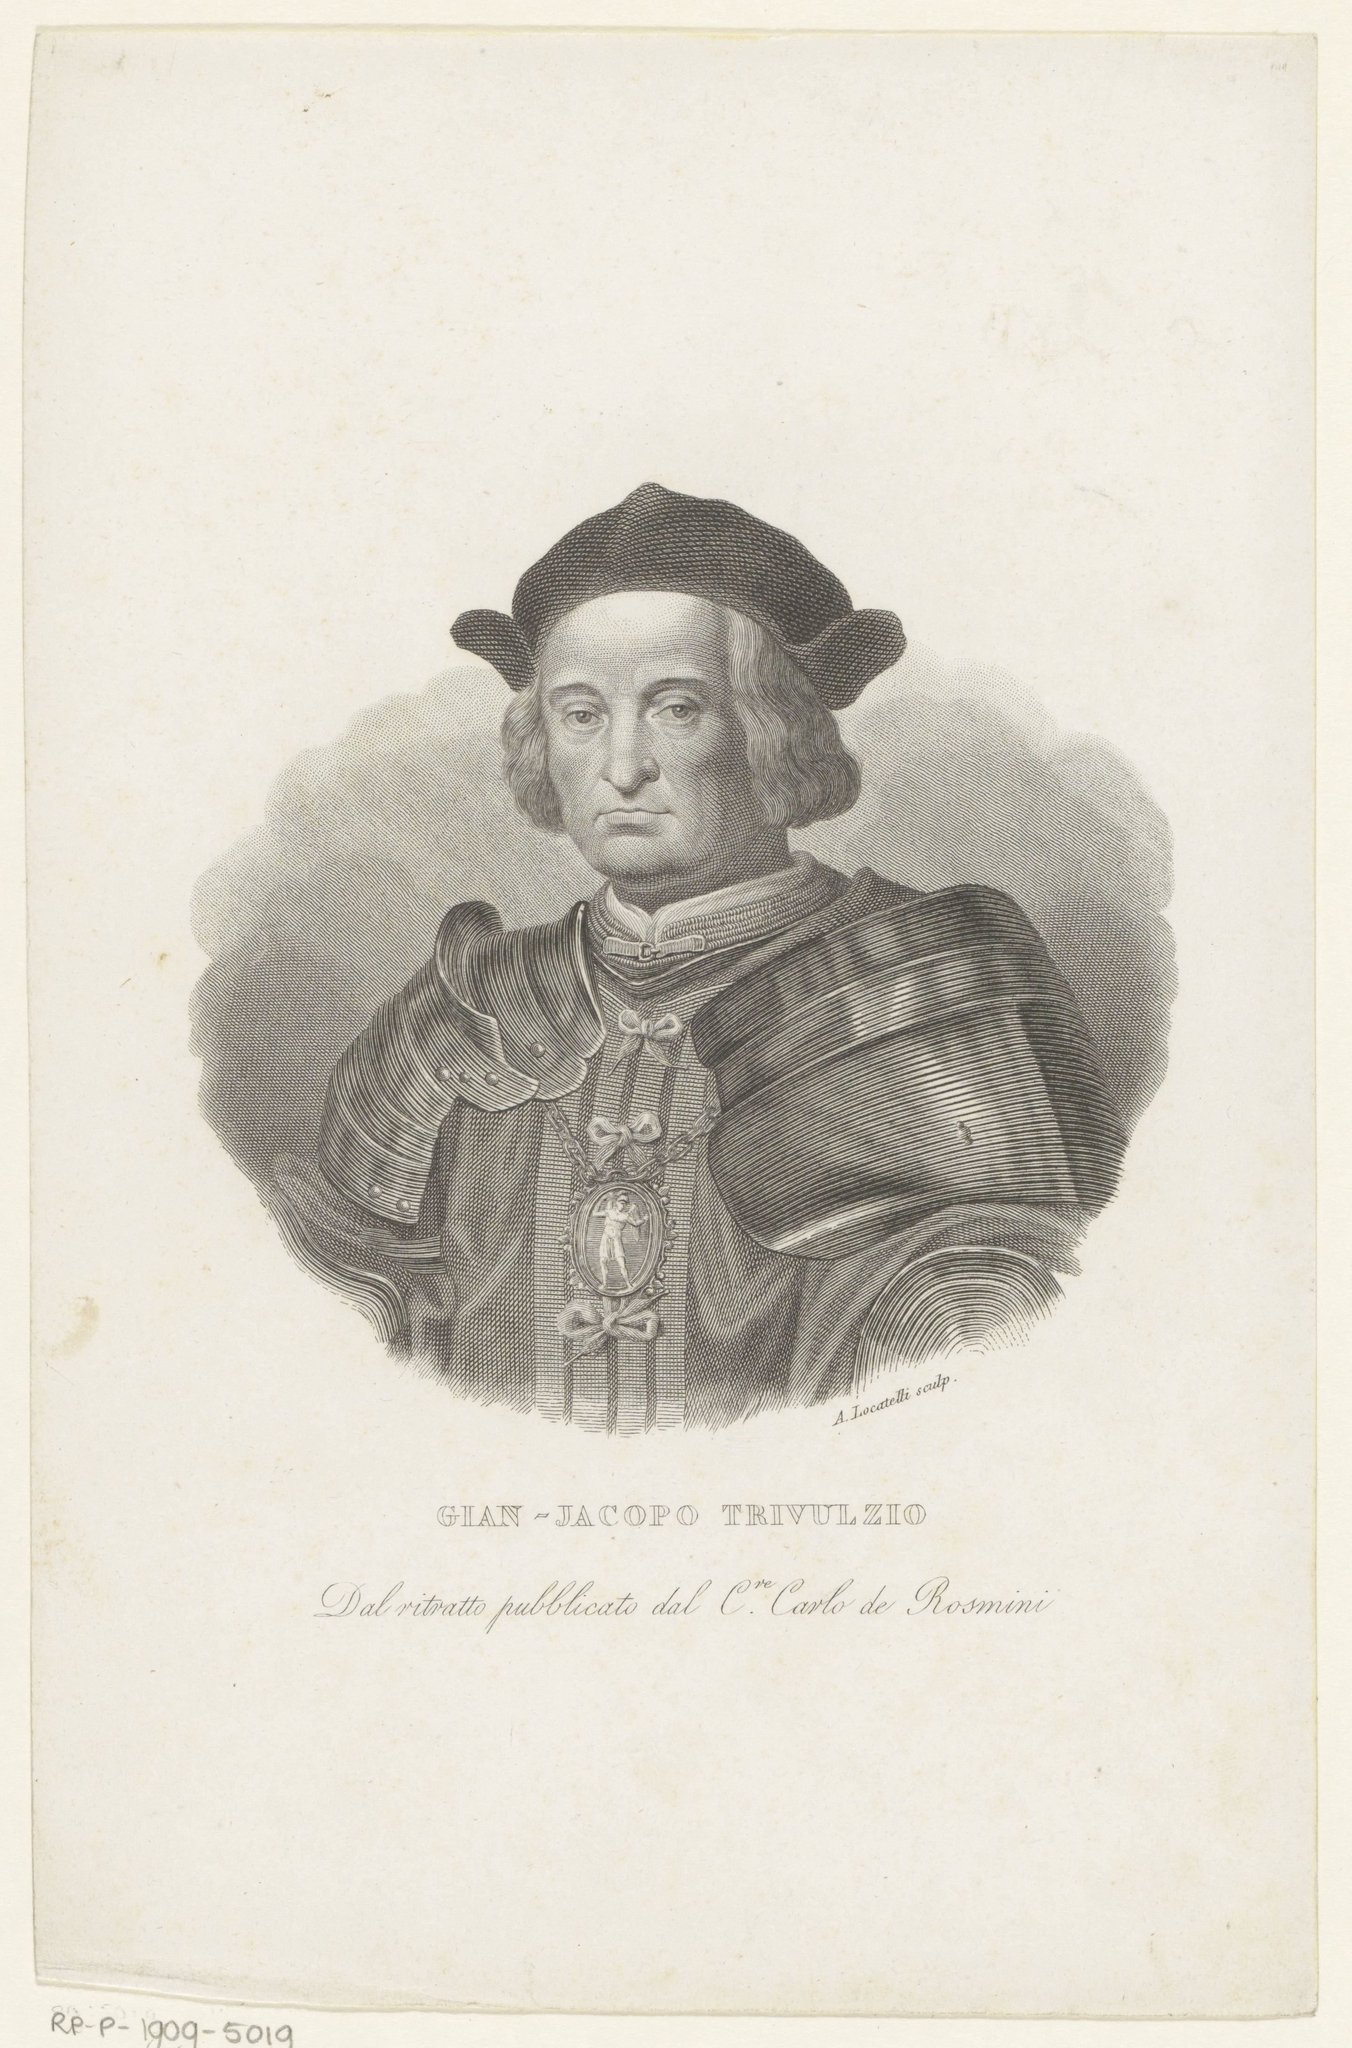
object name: print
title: Portret van Gian Giacomo Trivulzio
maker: antonio locatelli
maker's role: print maker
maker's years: 1800-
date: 1800-1899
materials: paper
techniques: engraving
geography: italy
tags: politician, historical persons, the soldier; the soldier's life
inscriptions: collector's mark: Lugt 2228